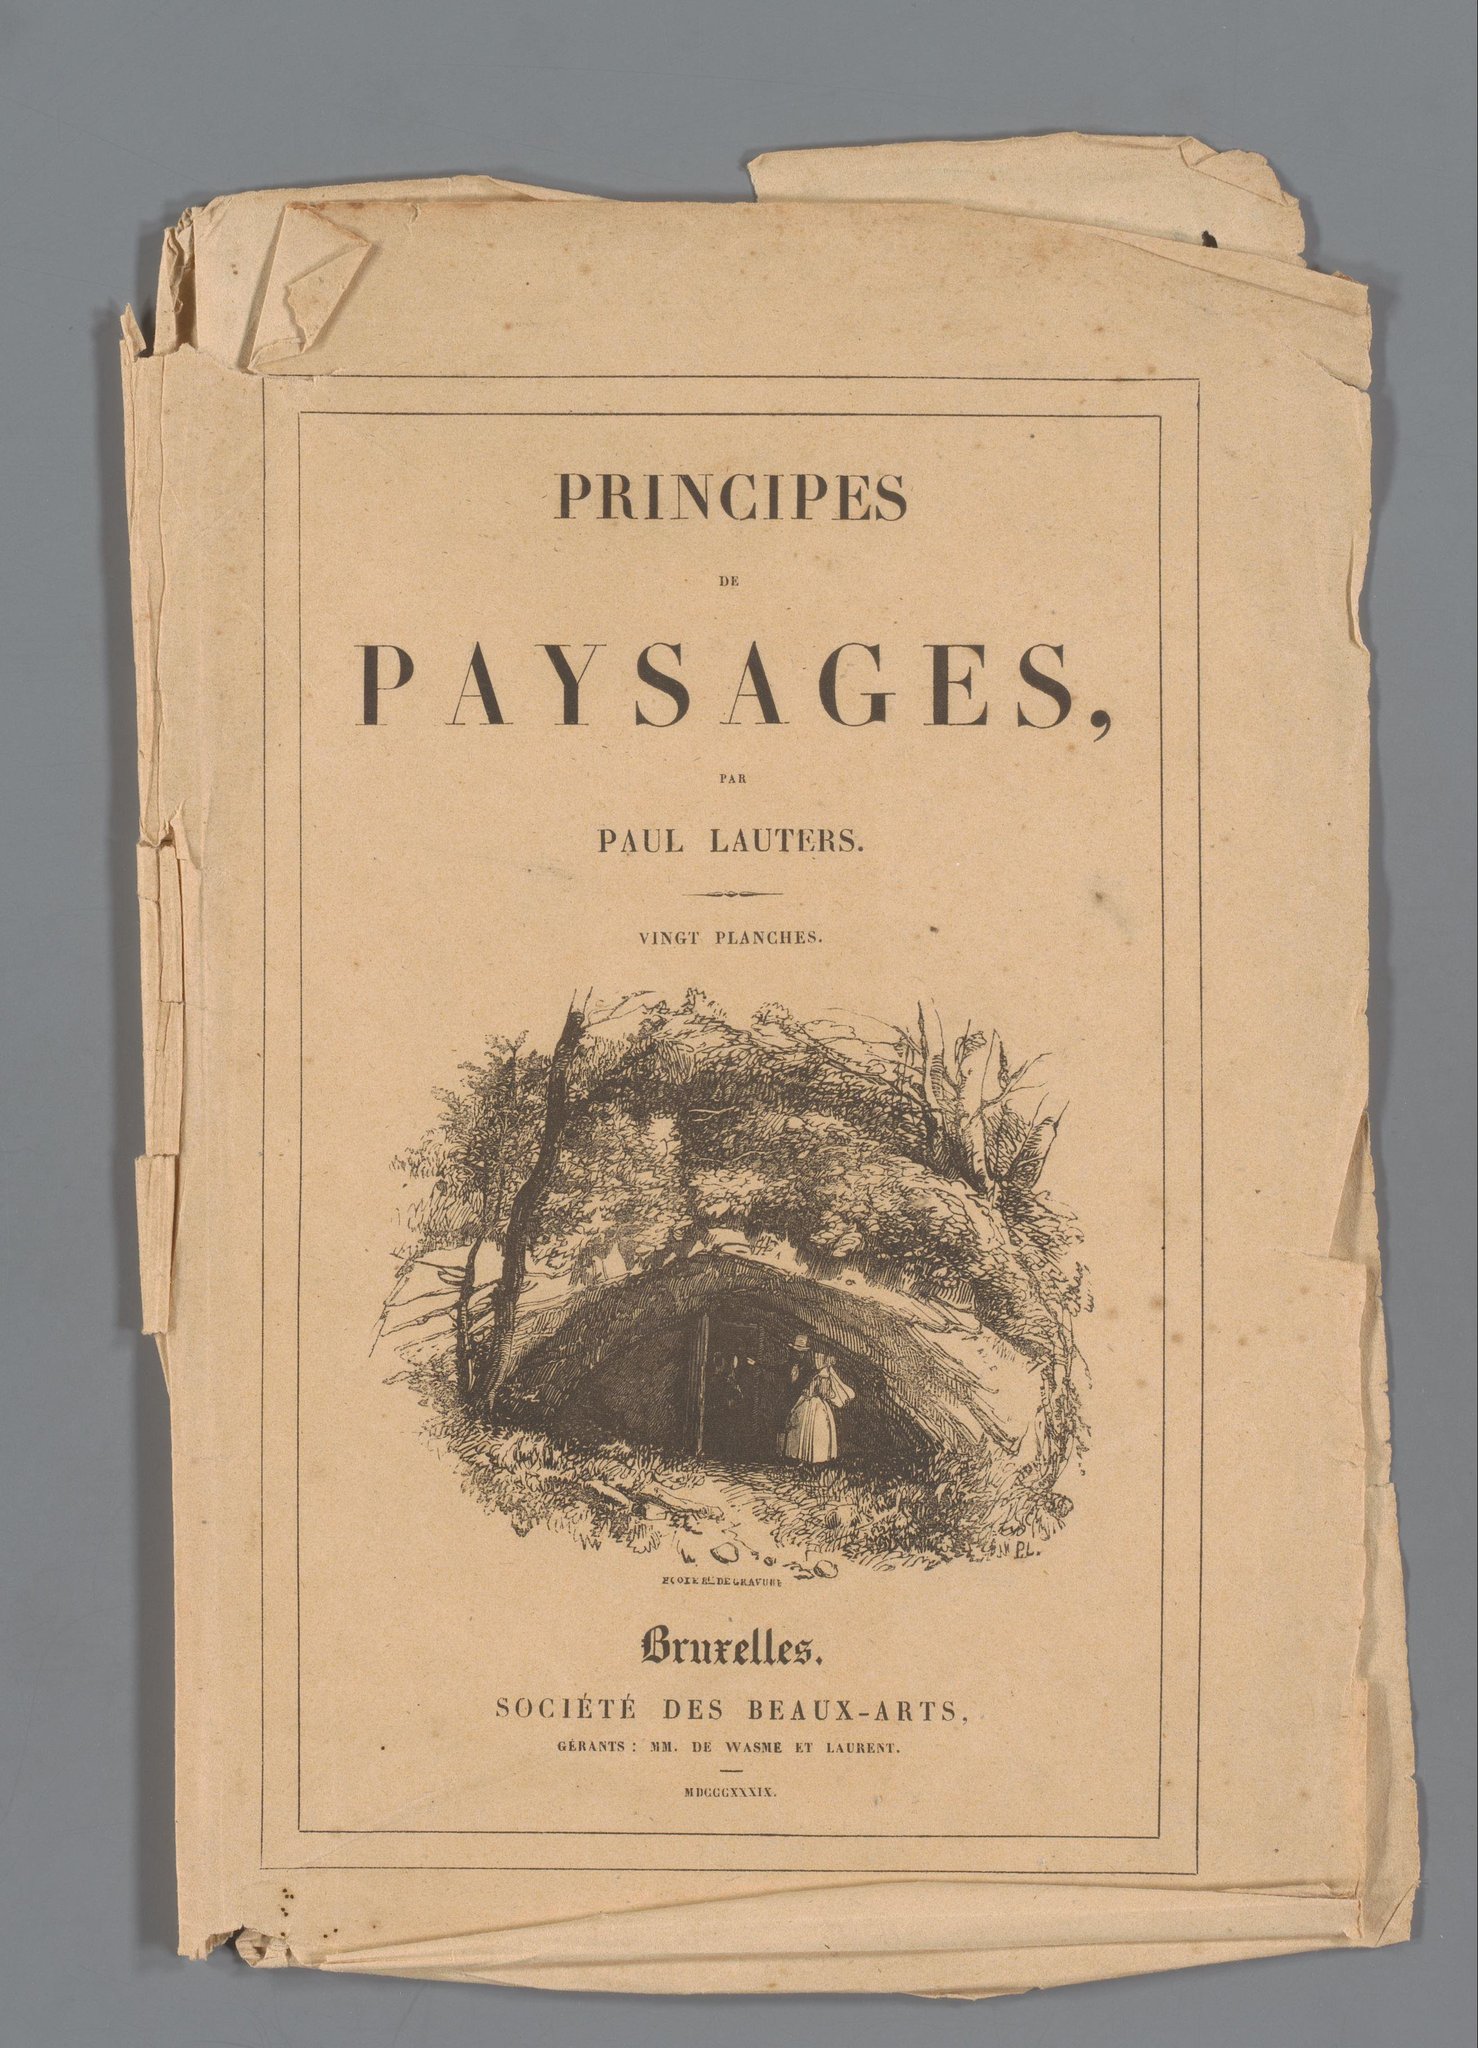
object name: wrapper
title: Principes de paysages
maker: paulus lauters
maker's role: print maker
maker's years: 1806-1875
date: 1839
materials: paper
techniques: lithograph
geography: brussels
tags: rock-formations, landscapes (+ landscape with figures, staffage)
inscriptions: collector's mark: Lugt 2228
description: Omslag voor een serie met twintig landschappen vervaardigd door Paulus Lauters.